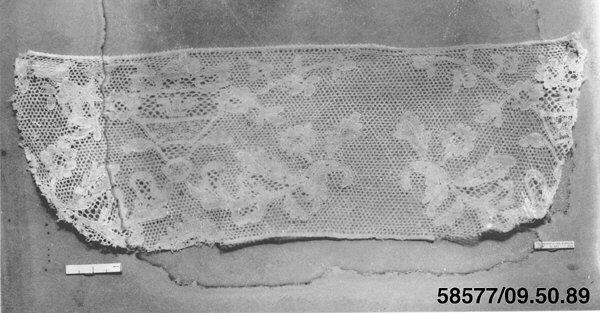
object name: fragment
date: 1701-1733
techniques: lace